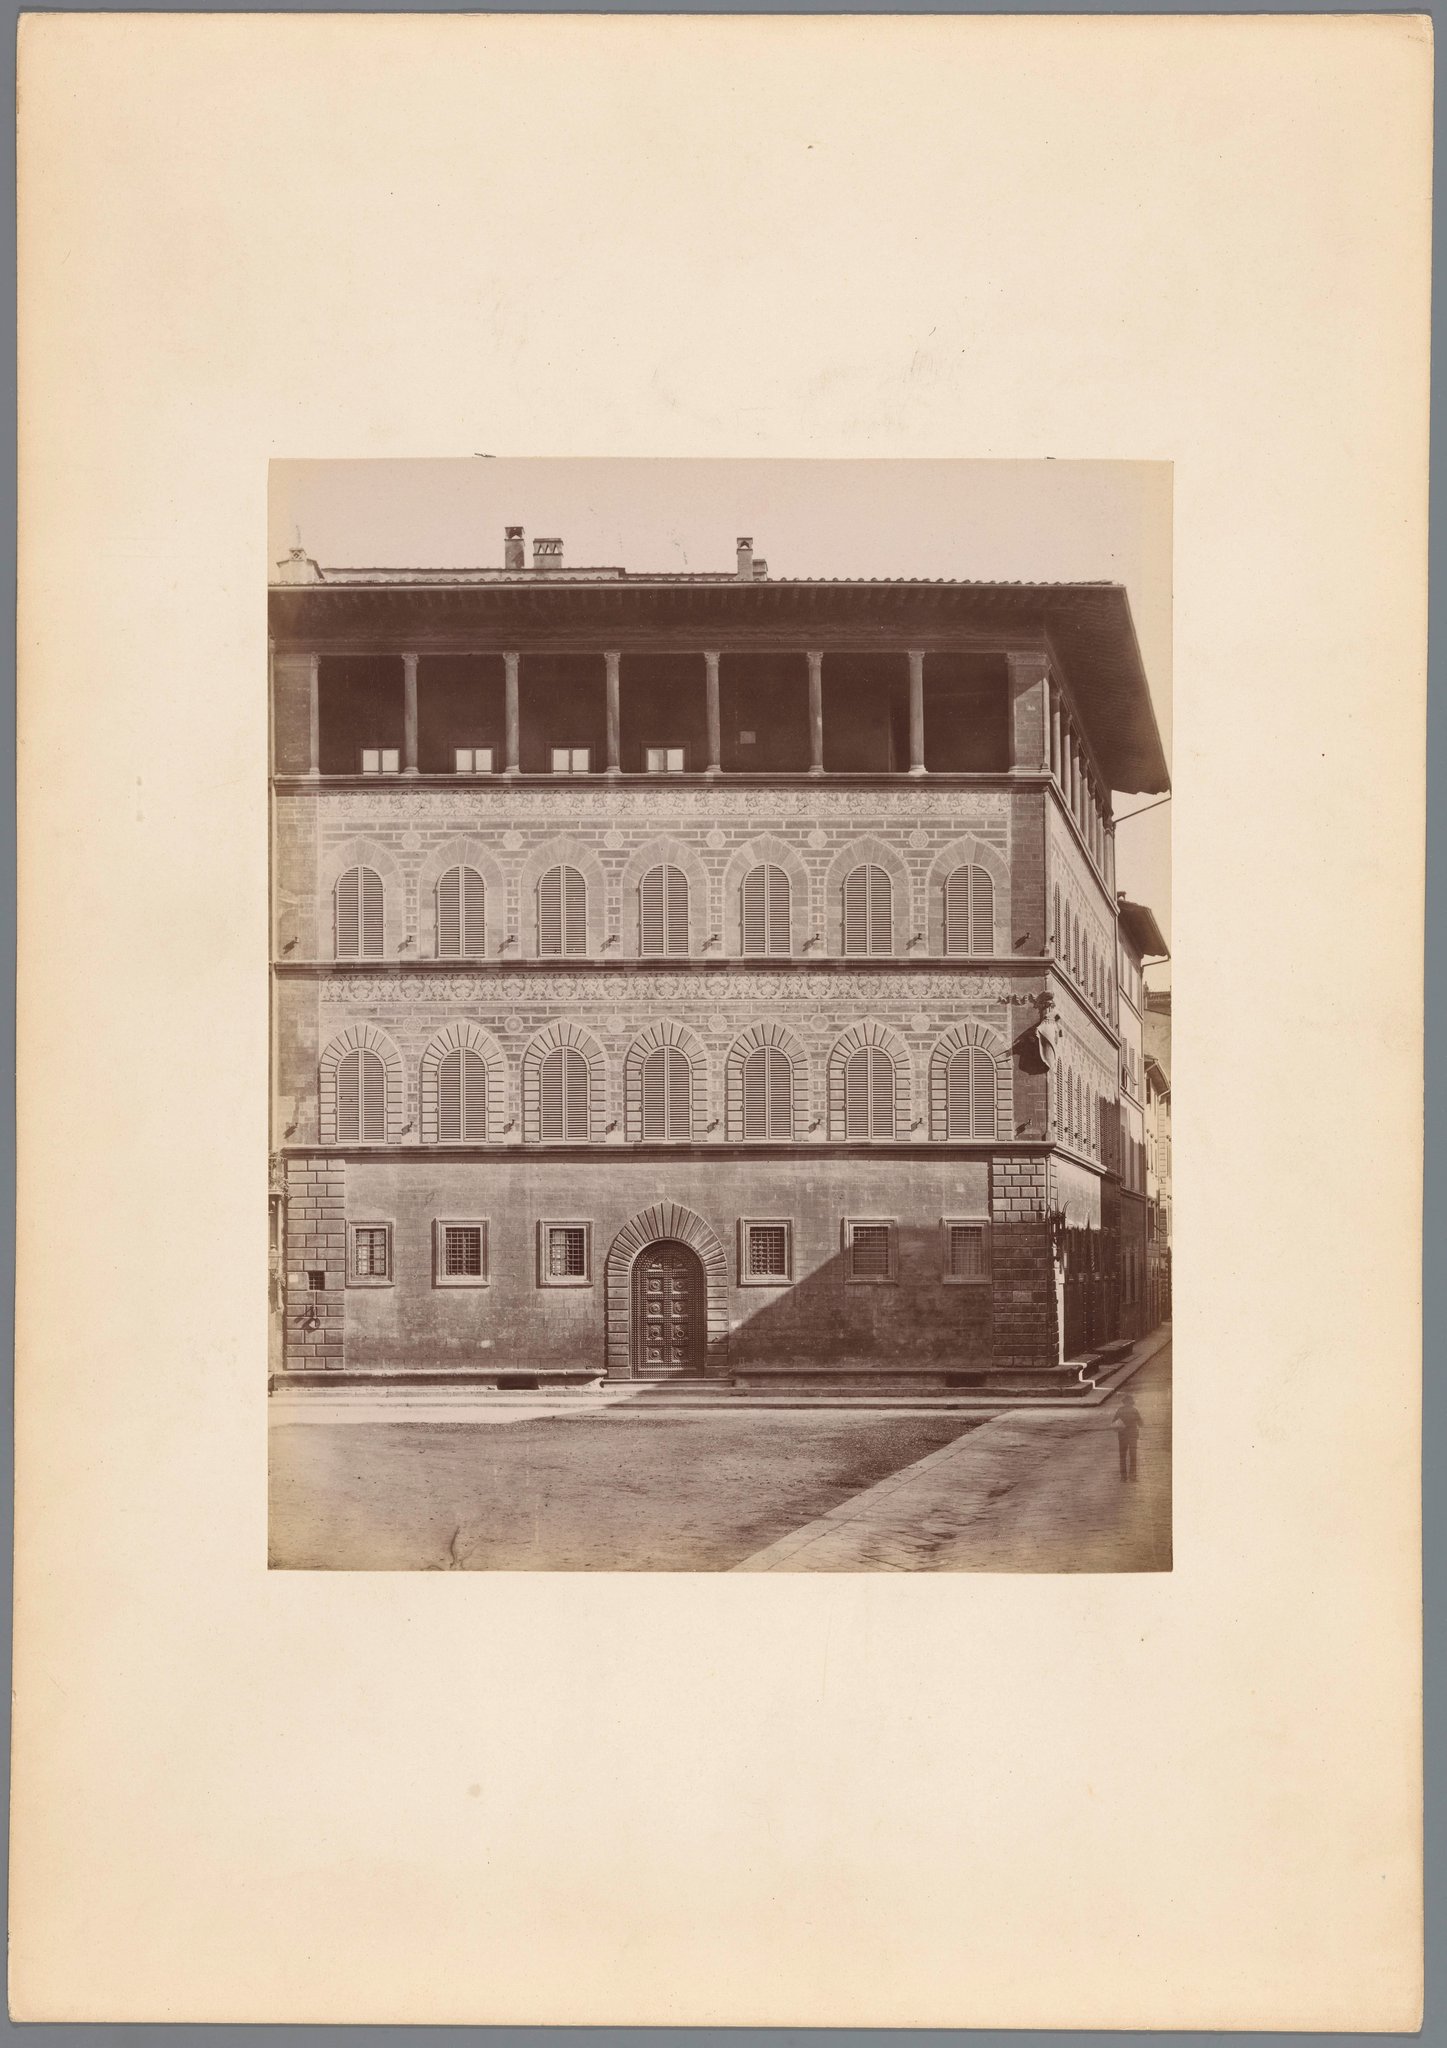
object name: photograph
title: Façade van een gebouw vermoedelijk in Italïe, met op de bovenste verdieping een zuilengalerij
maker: Anonymous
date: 1875-1900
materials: cardboard, photographic support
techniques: albumen print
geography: europe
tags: hôtel, i.e. small palace in city, façade (of house or building), europe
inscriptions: collector's mark: ‘INSTITUUT VOOR KUNST-NIJVERHEIDSONDERWIJS GABRIËL METSUSTRAAT No. 16 AMSTERDAM’, collector's mark: ‘KUNSTNIJVERHEIDSCHOOL QUELLINUS AMSTERDAM FRANS HALSSTRAAT 14.’